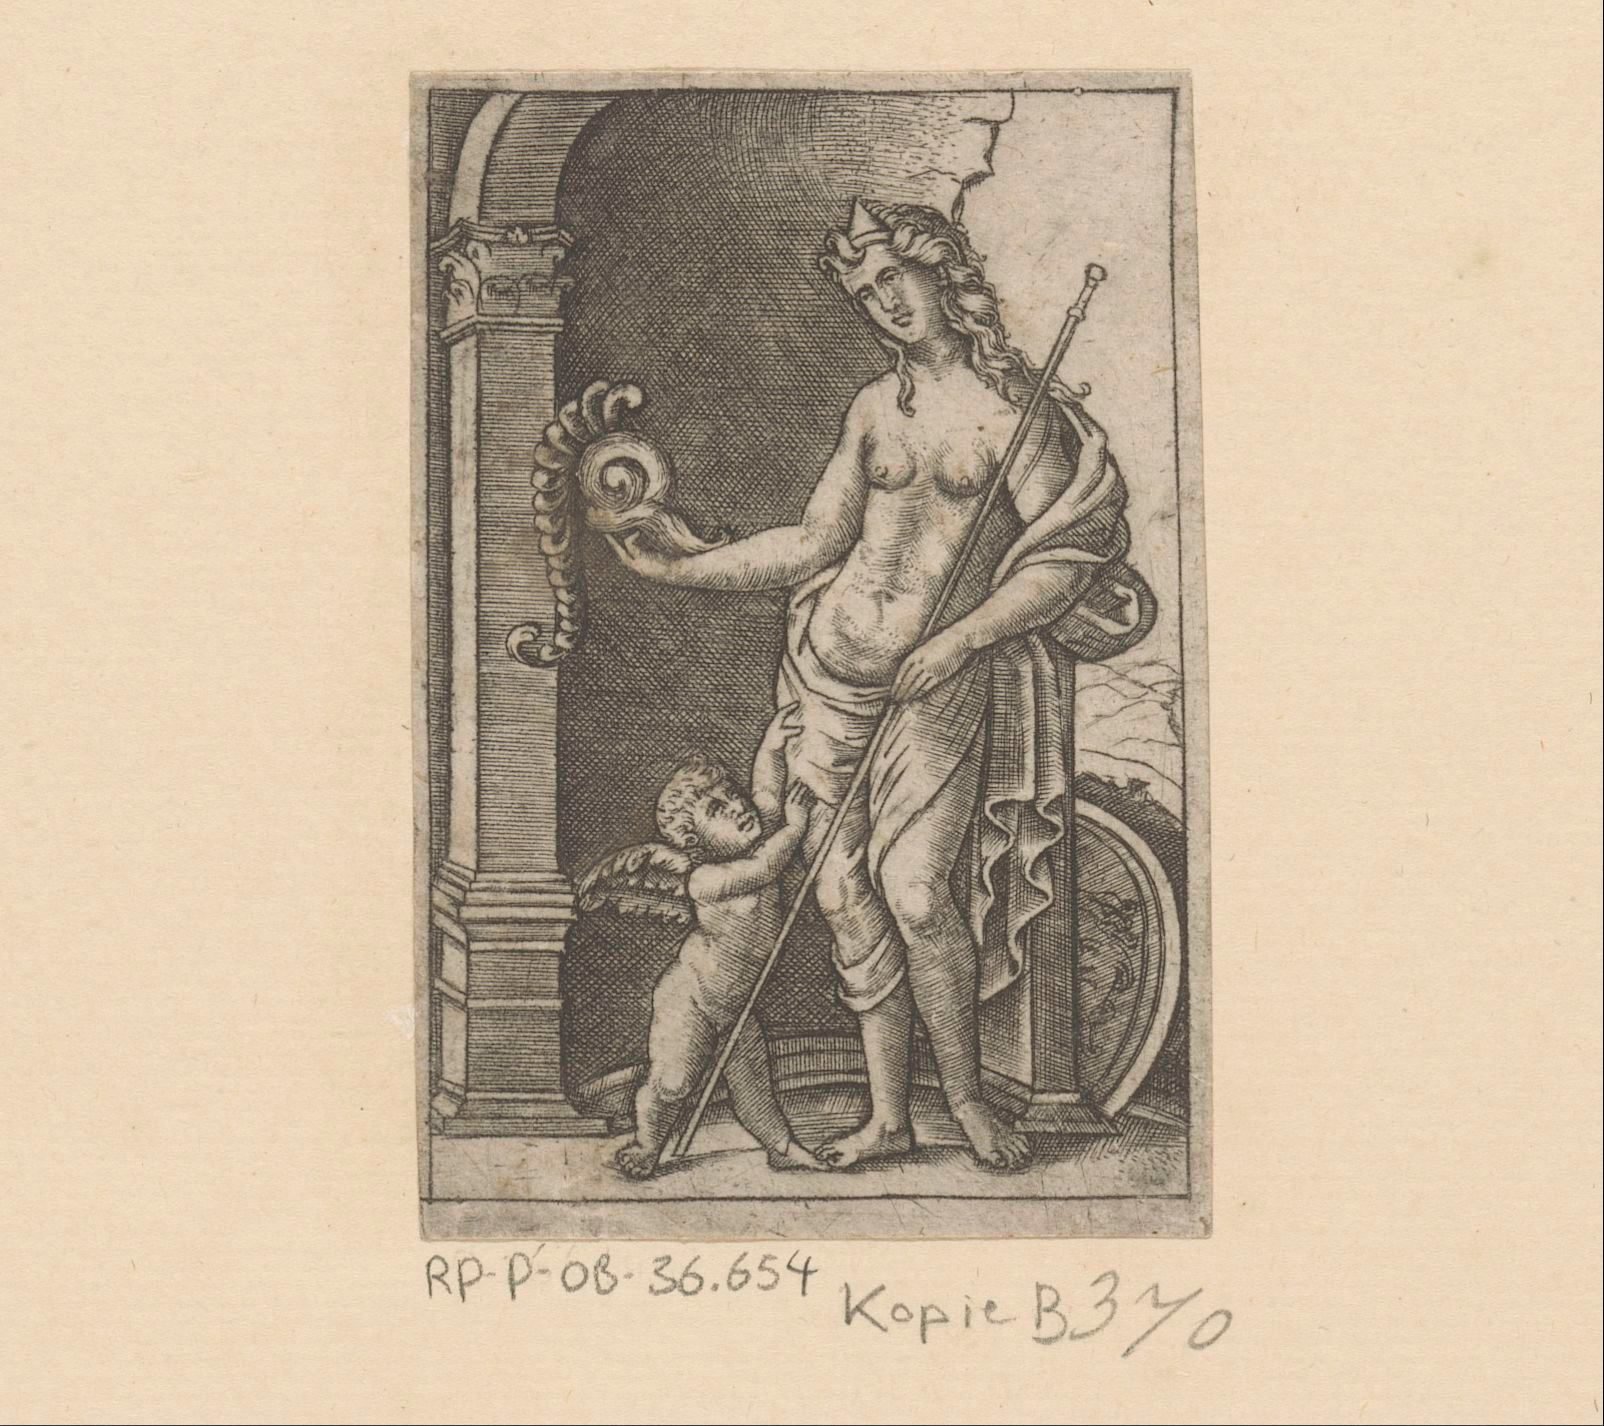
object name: print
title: Minerva met putto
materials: paper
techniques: engraving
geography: italy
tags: helmet, protective weapons: shield, (story of) minerva (pallas, athena), cupids: 'amores', 'amoretti', 'putti'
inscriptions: collector's mark: Lugt 12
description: Voor een nis staat een vrouw met ontbloot bovenlichaam, mogelijk Minerva. Zij houdt een helm in haar rechterhand en een staf in haar linkerhand. Links staat een putto en rechts leunt een schild tegen de muur.